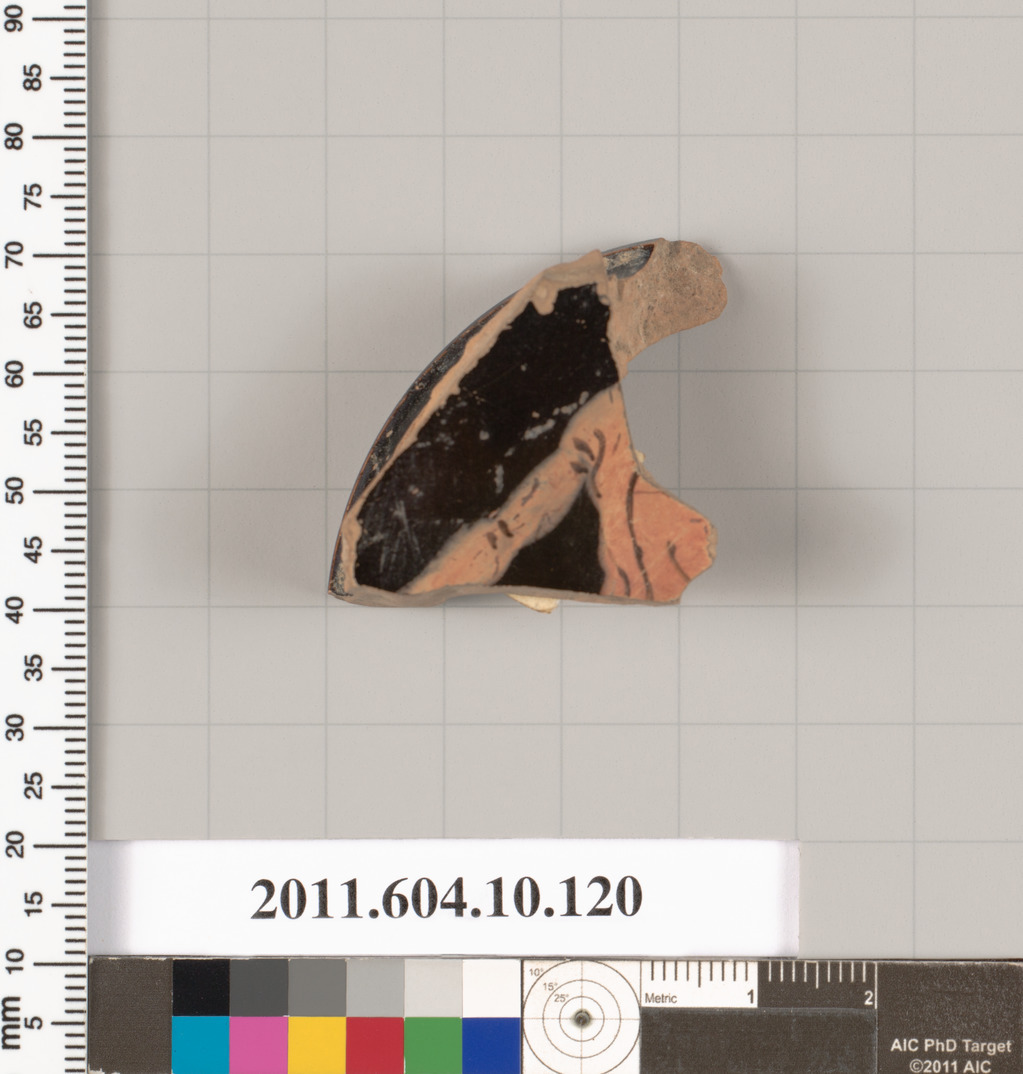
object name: kylix fragment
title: Terracotta fragment of a stemless kylix (drinking cup)?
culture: etruscan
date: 434-368 BCE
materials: terracotta